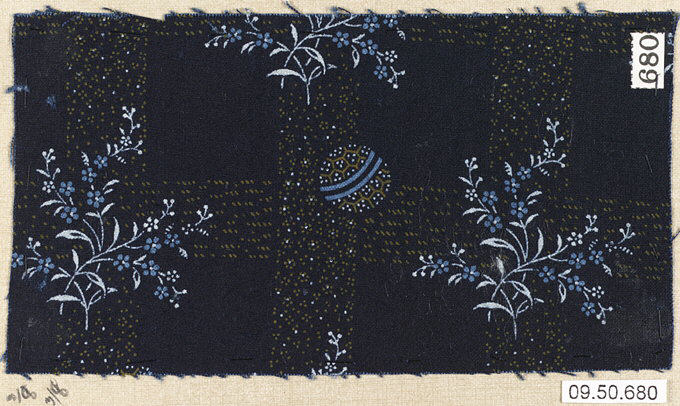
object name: piece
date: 1801-1900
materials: cotton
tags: flowers,leaves